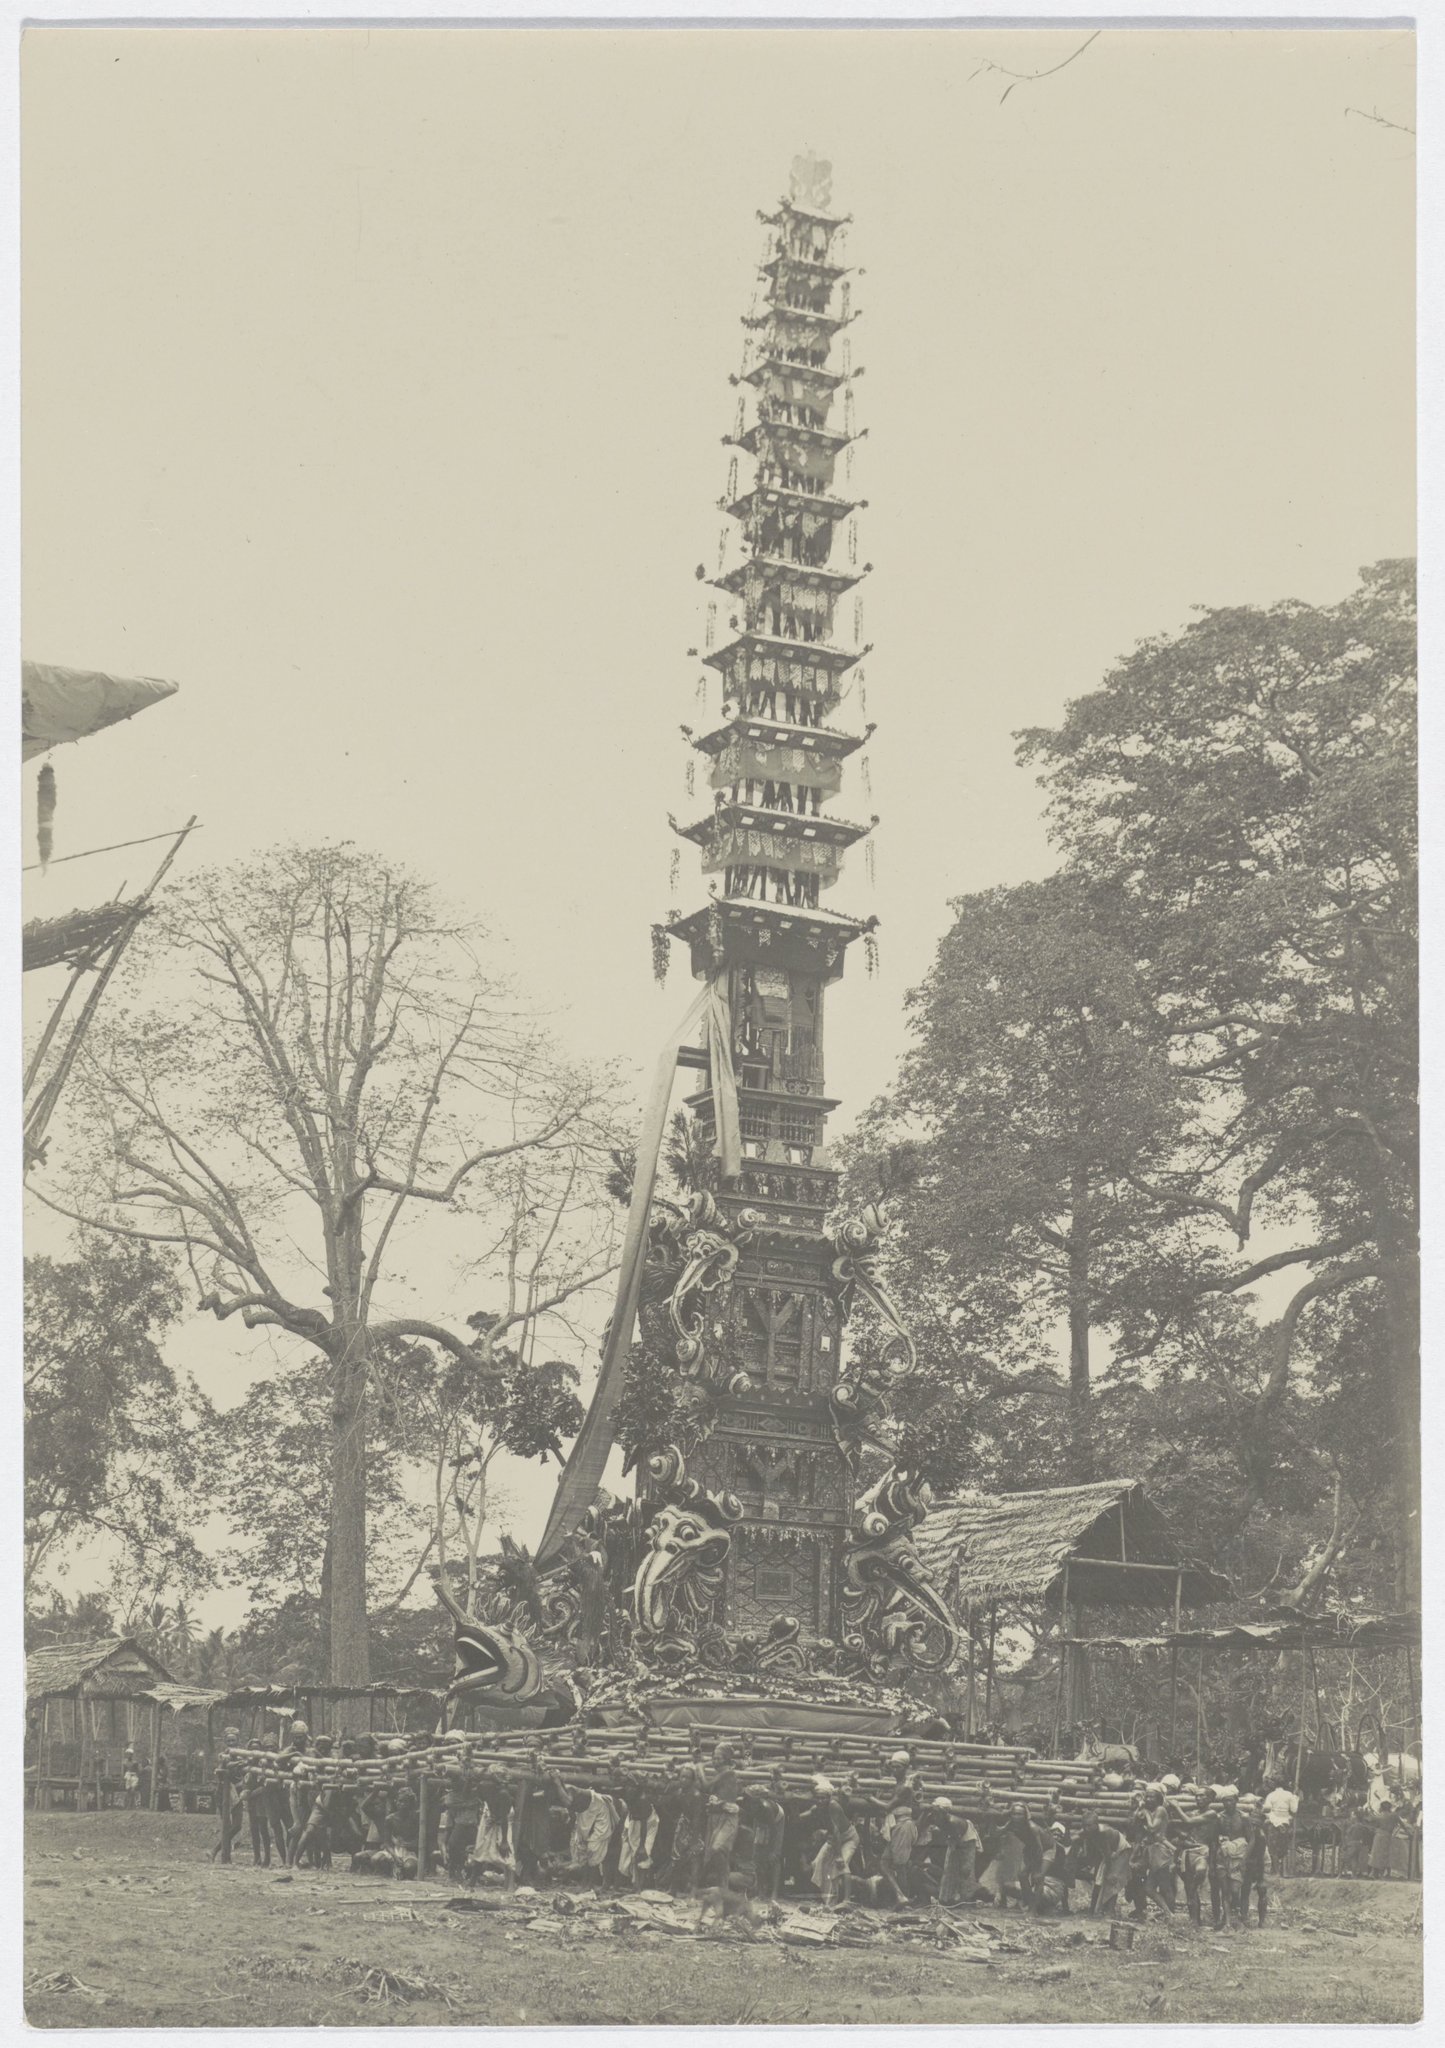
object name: photograph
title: Een gedecoreerde stellage met afgebeelde dierenkoppen voor nen hindu crematie ritueel.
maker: johanna hermina marmelstein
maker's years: 1897-1990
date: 1900-1915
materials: paper, photographic support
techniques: albumen print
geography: jakarta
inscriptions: inscription: ‘Stellage voor lijkverbranding.’